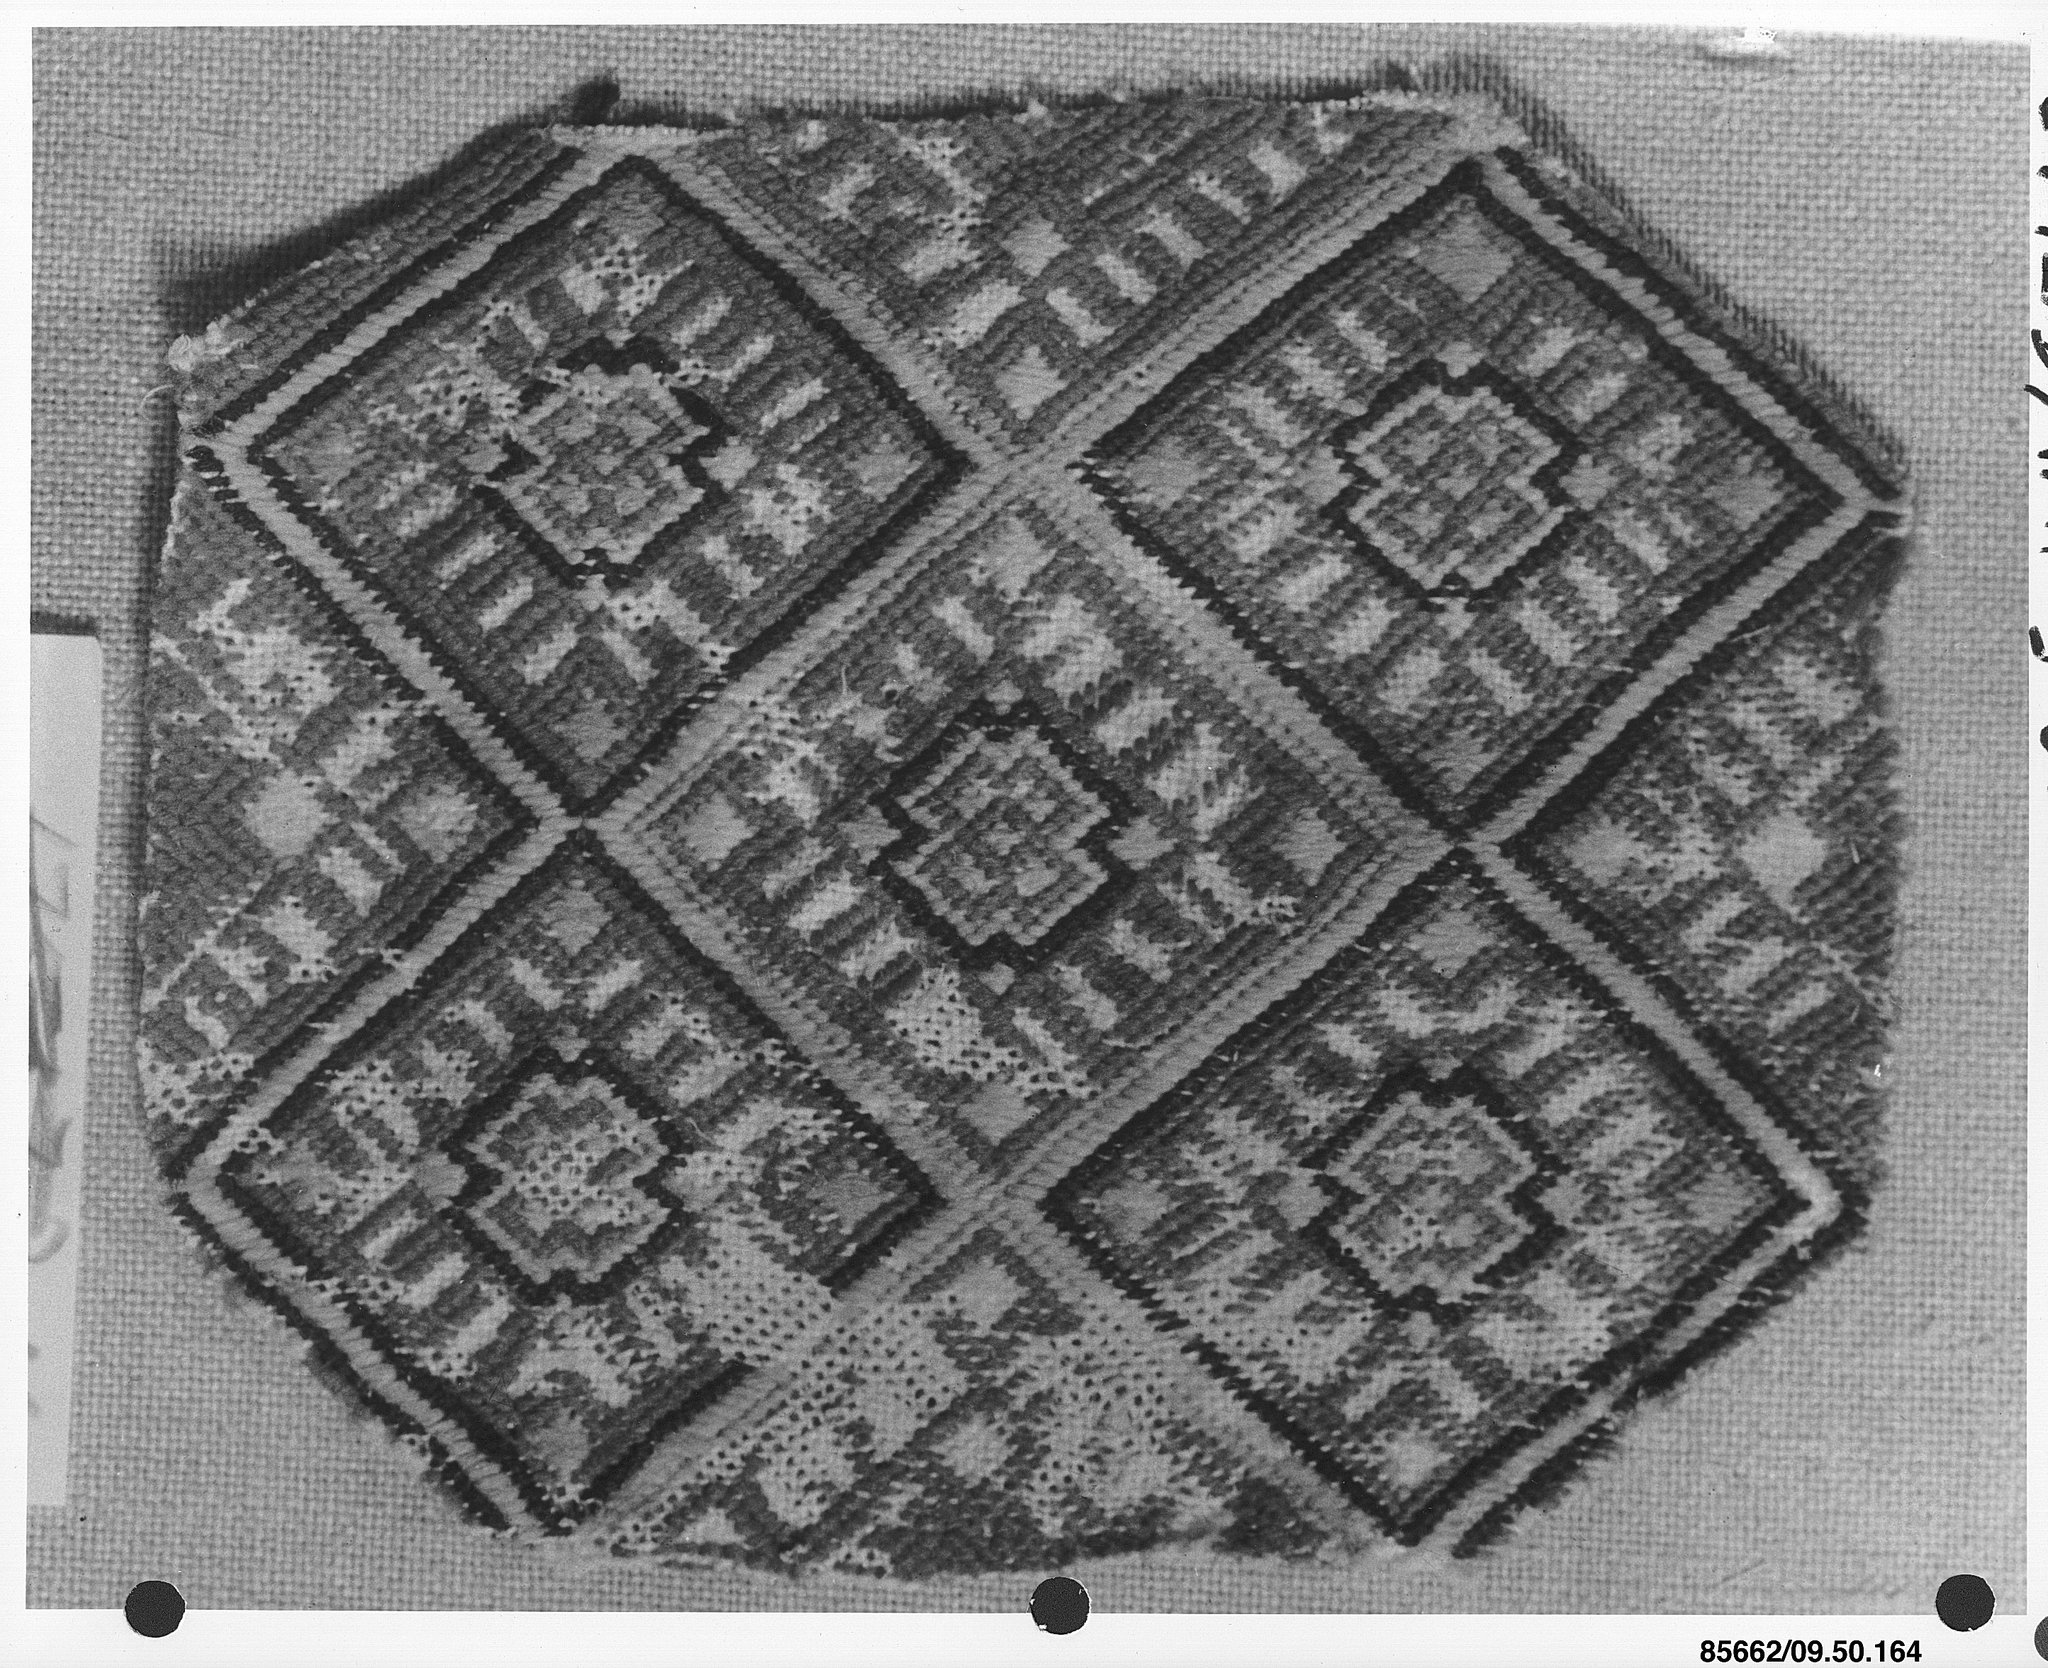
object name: costume fragment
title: Peasant costume fragment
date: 1701-1900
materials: canvas, wool